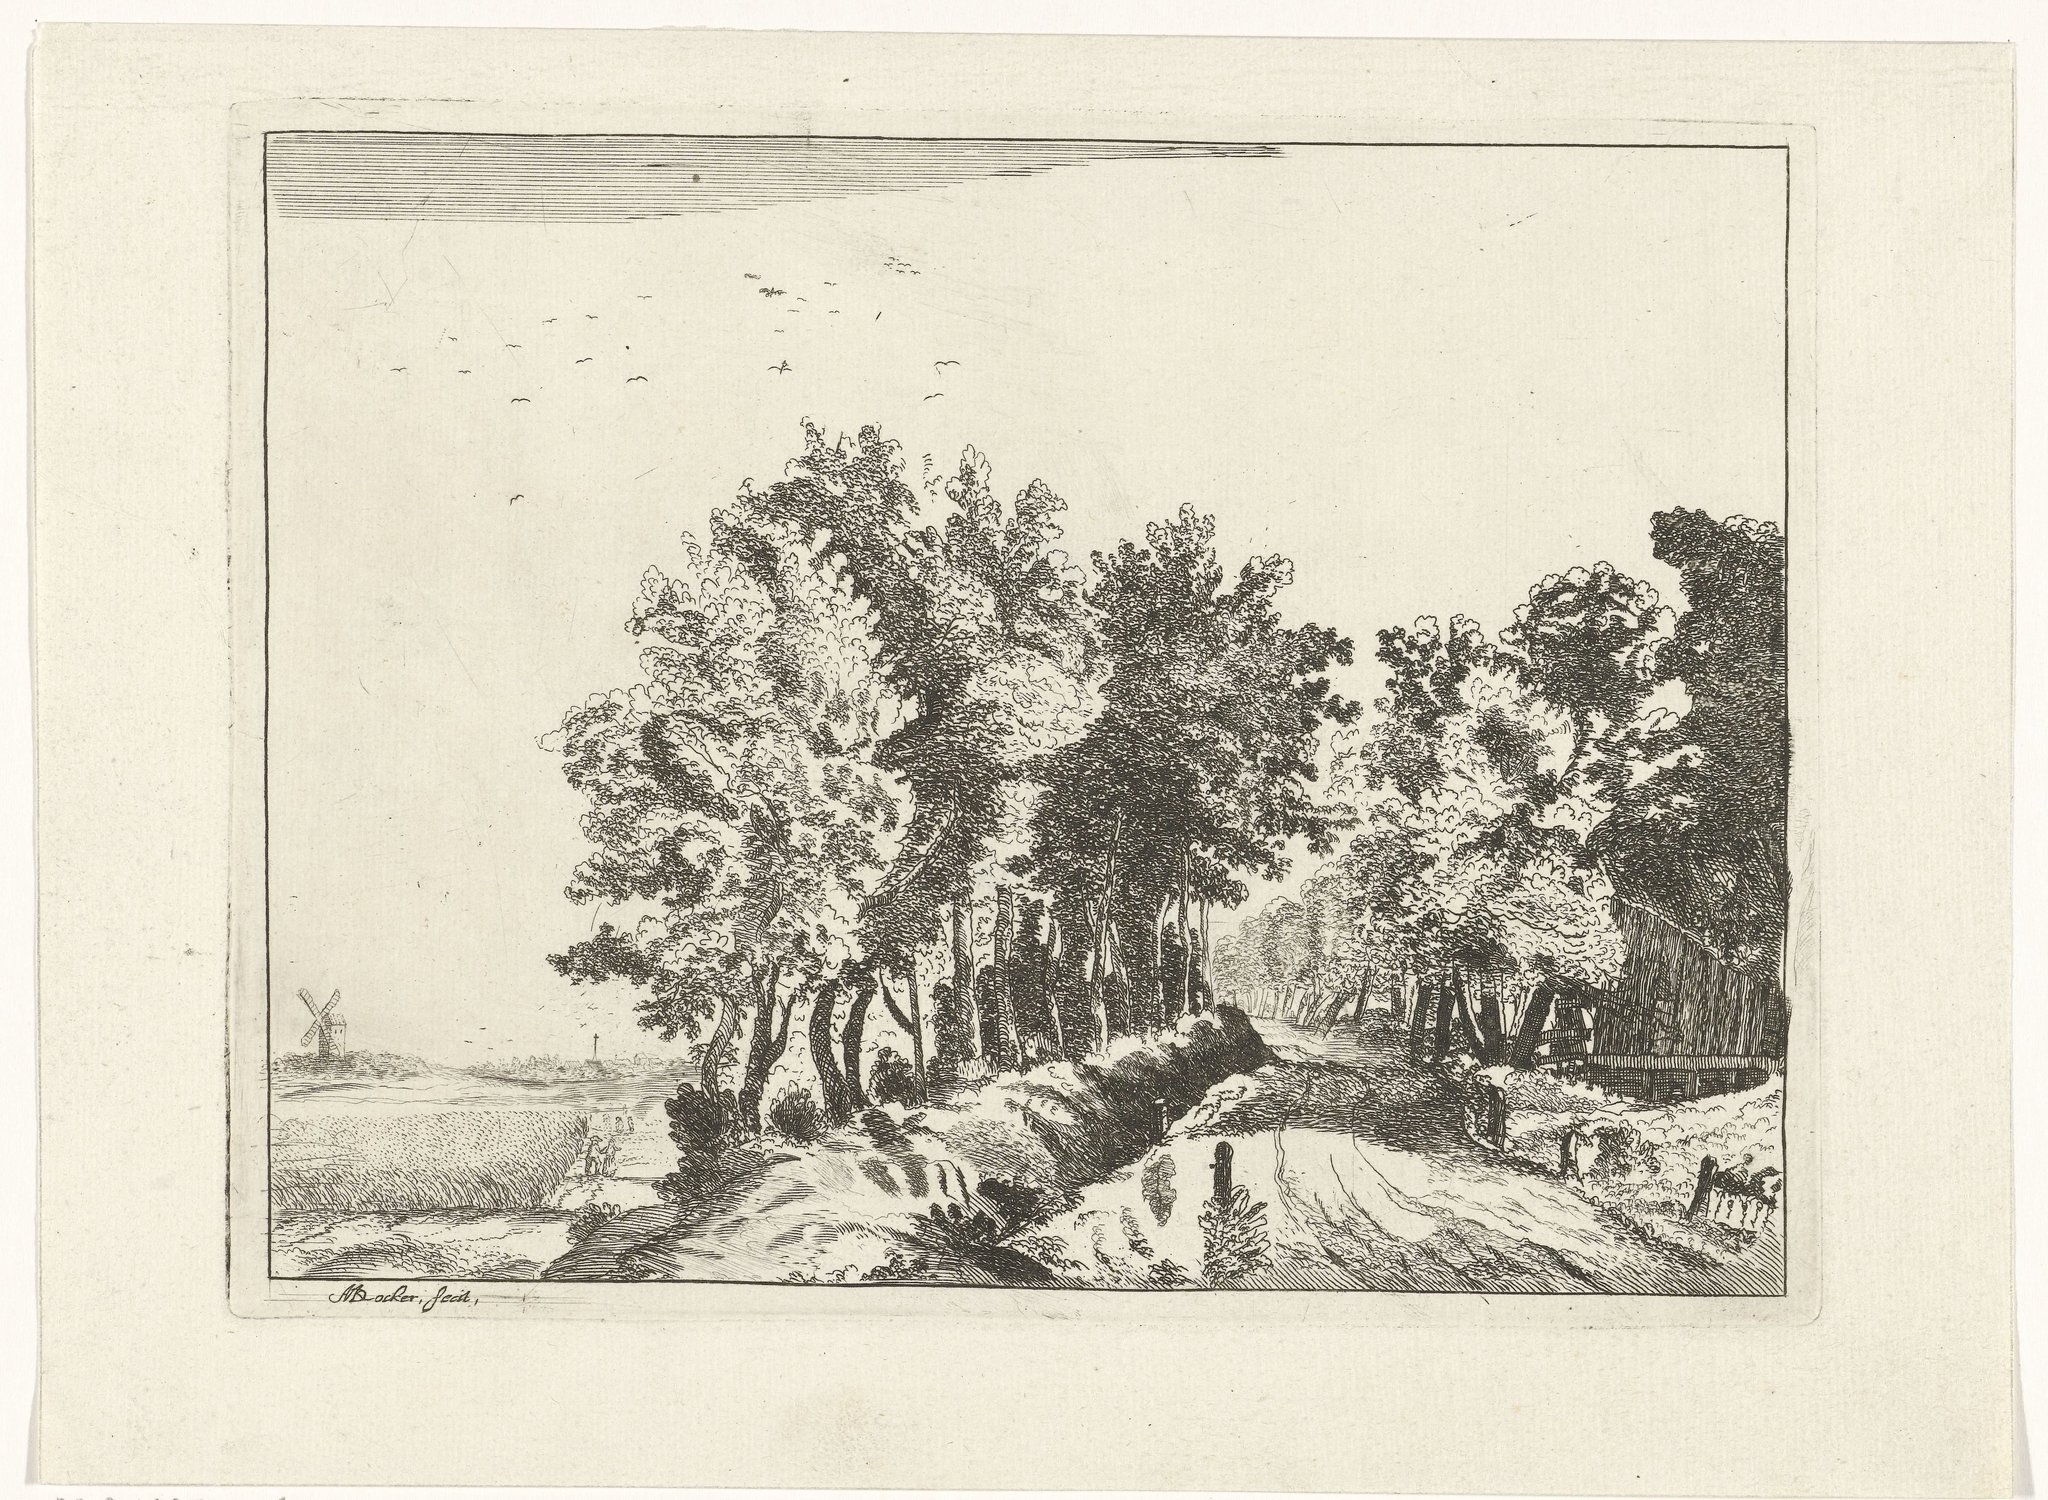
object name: print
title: Landschap met een hut aan de weg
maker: anna maria de koker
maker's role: print maker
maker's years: -1698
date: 1640-1698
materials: paper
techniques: etching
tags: farmers, church (exterior), road, path, cottage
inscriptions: collector's mark: Lugt 2760, collector's mark: Lugt 2228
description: Landschap met een landweg die geflankeerd wordt door geboomte. Rechts van de weg staat een houten hut of schuur en aan de linkerzijde is een korenveld te zien, waar een boer en een boerin hand in hand lopen. Op de achtergrond staat een windmolen en in de lucht vliegen enkele vogels.